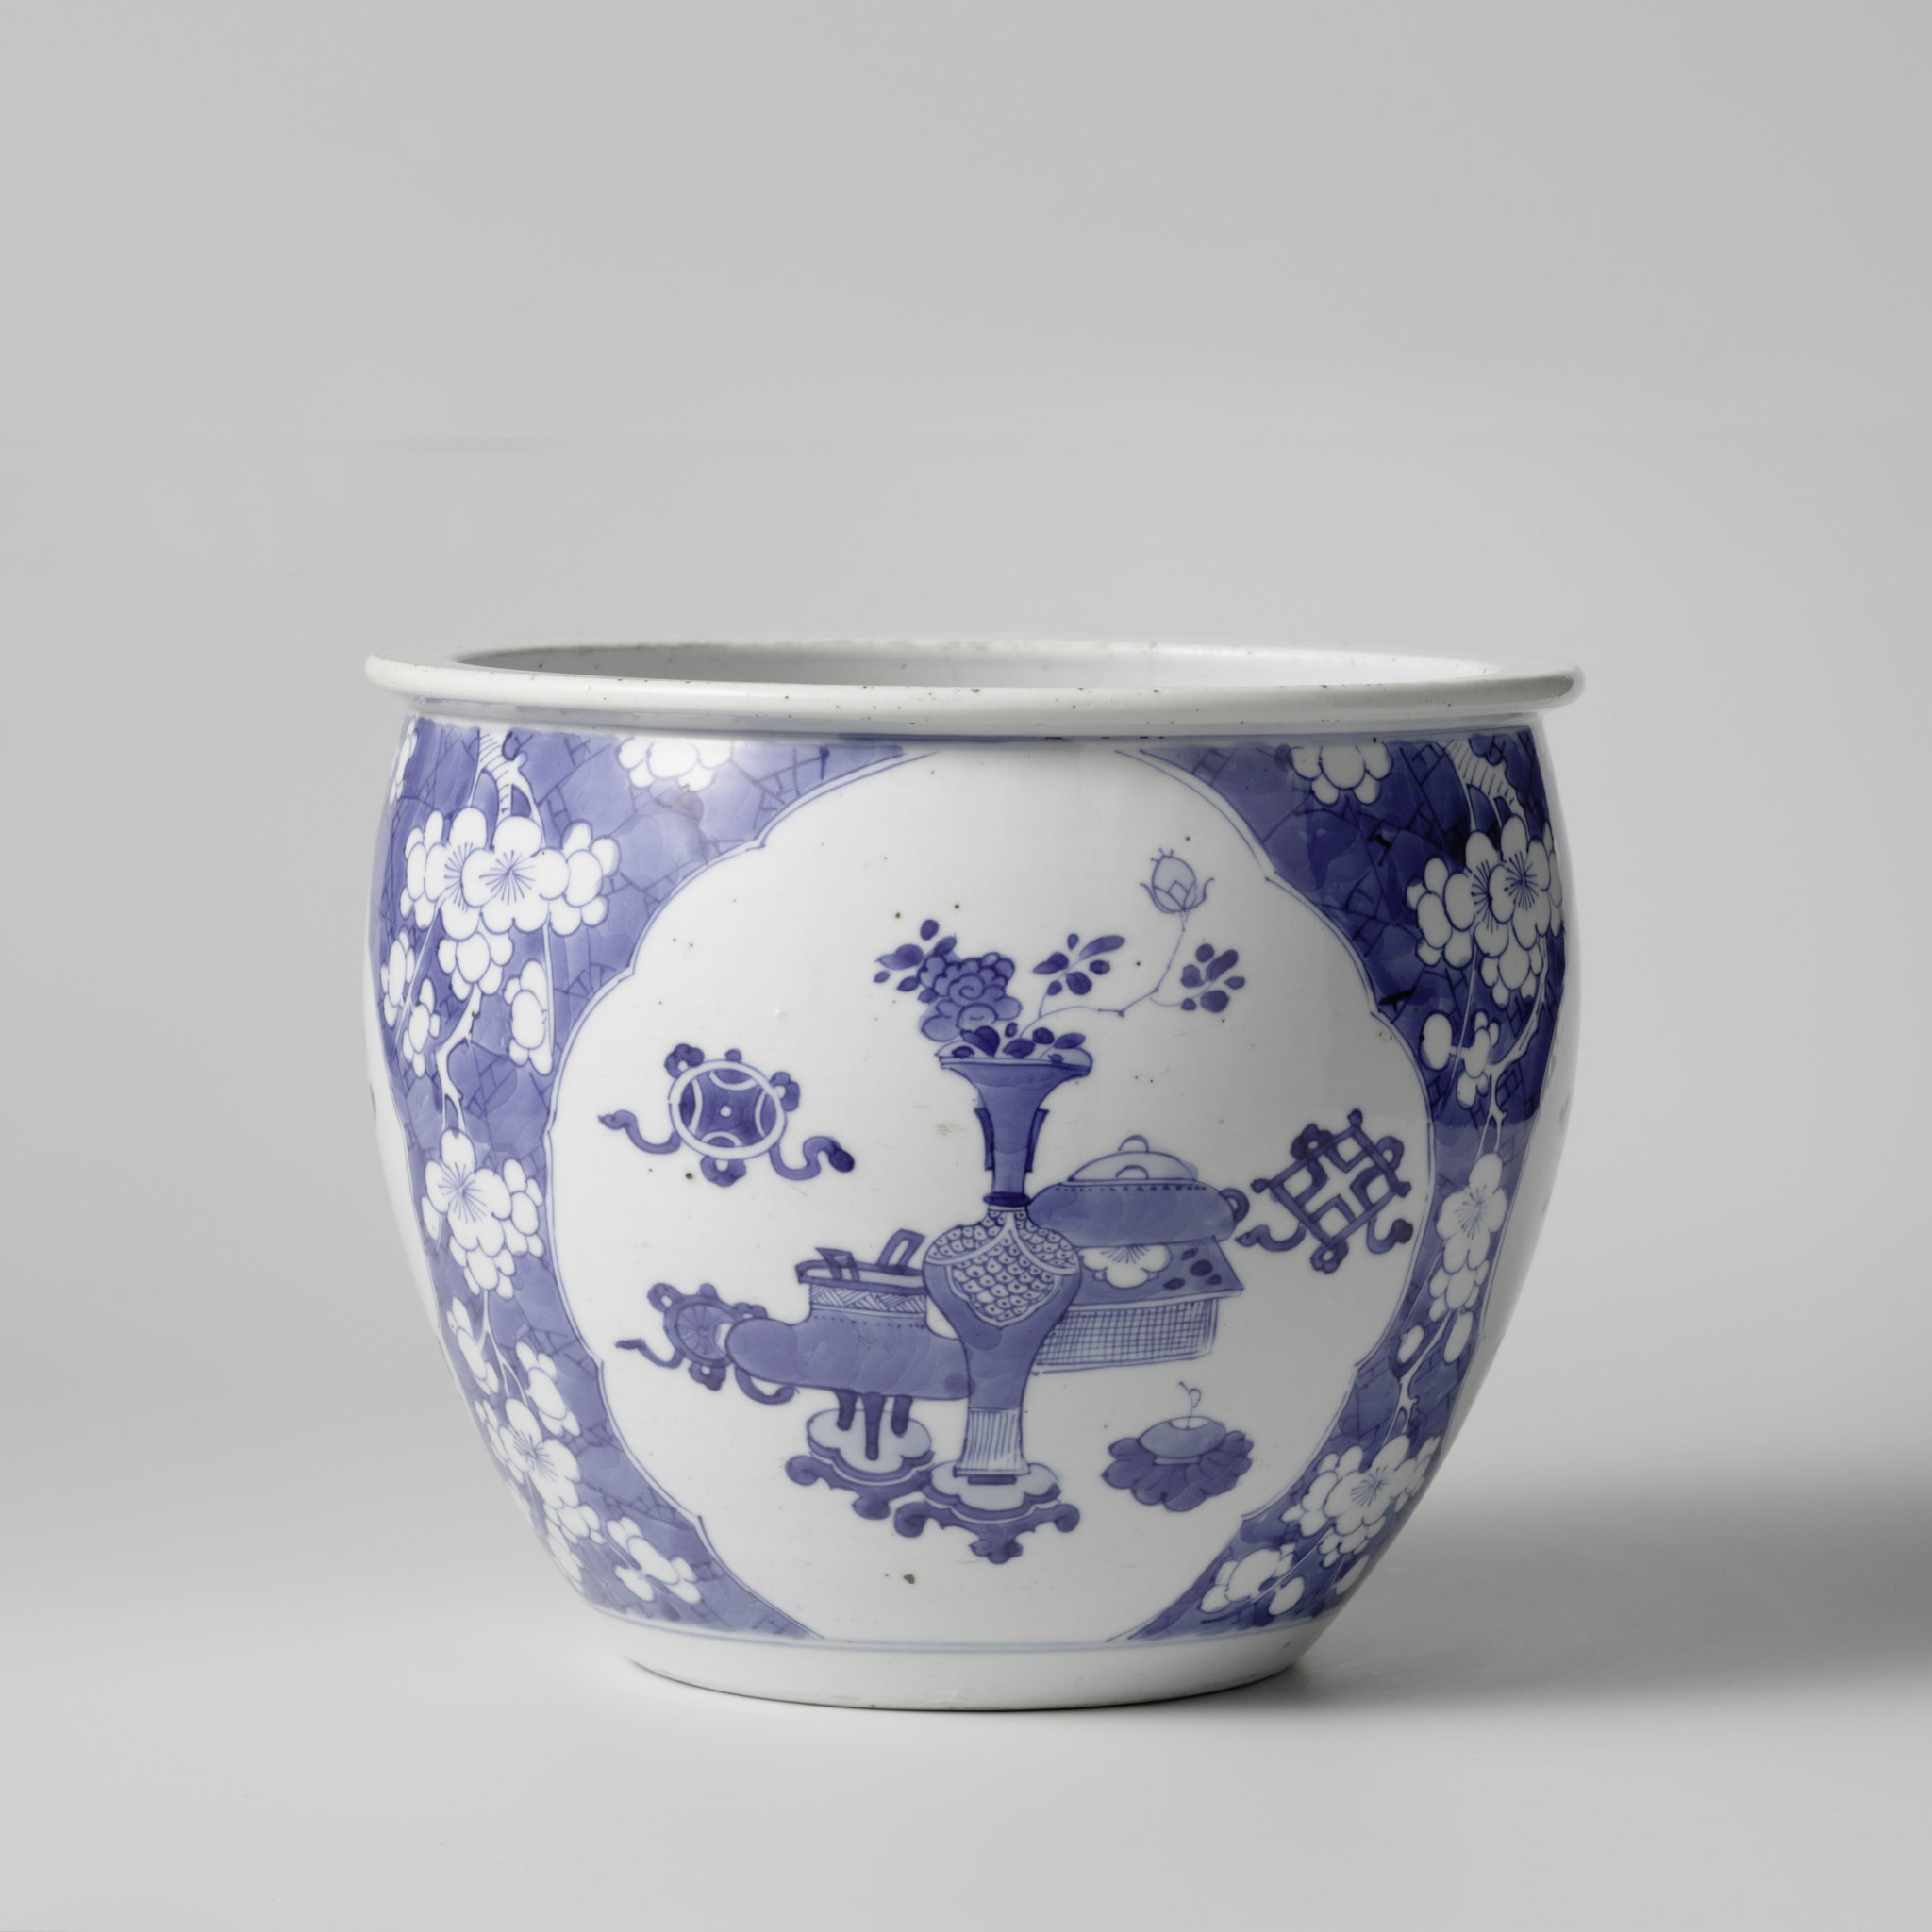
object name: pot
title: Flowerpot with panels and prunus sprays on crackled ice ground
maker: Anonymous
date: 1900-1920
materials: cobalt, glaze, paint, porcelain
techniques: firing, turning, vitrification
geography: china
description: Bloempot van porselein met platte rand, beschilderd in onderglazuur blauw. De wand is bedekt met een 'crackled ice' grond in blauw met prunustakken in reserve en drie uitgespaarde gelobde cartouches gevuld met antiquiteiten (vaas, pauwenveren, driepoot, wierrookbrander, scepter) en kostbaarheden (parel, munt, muzieksteen, ruit, boeken). Blauw-wit.